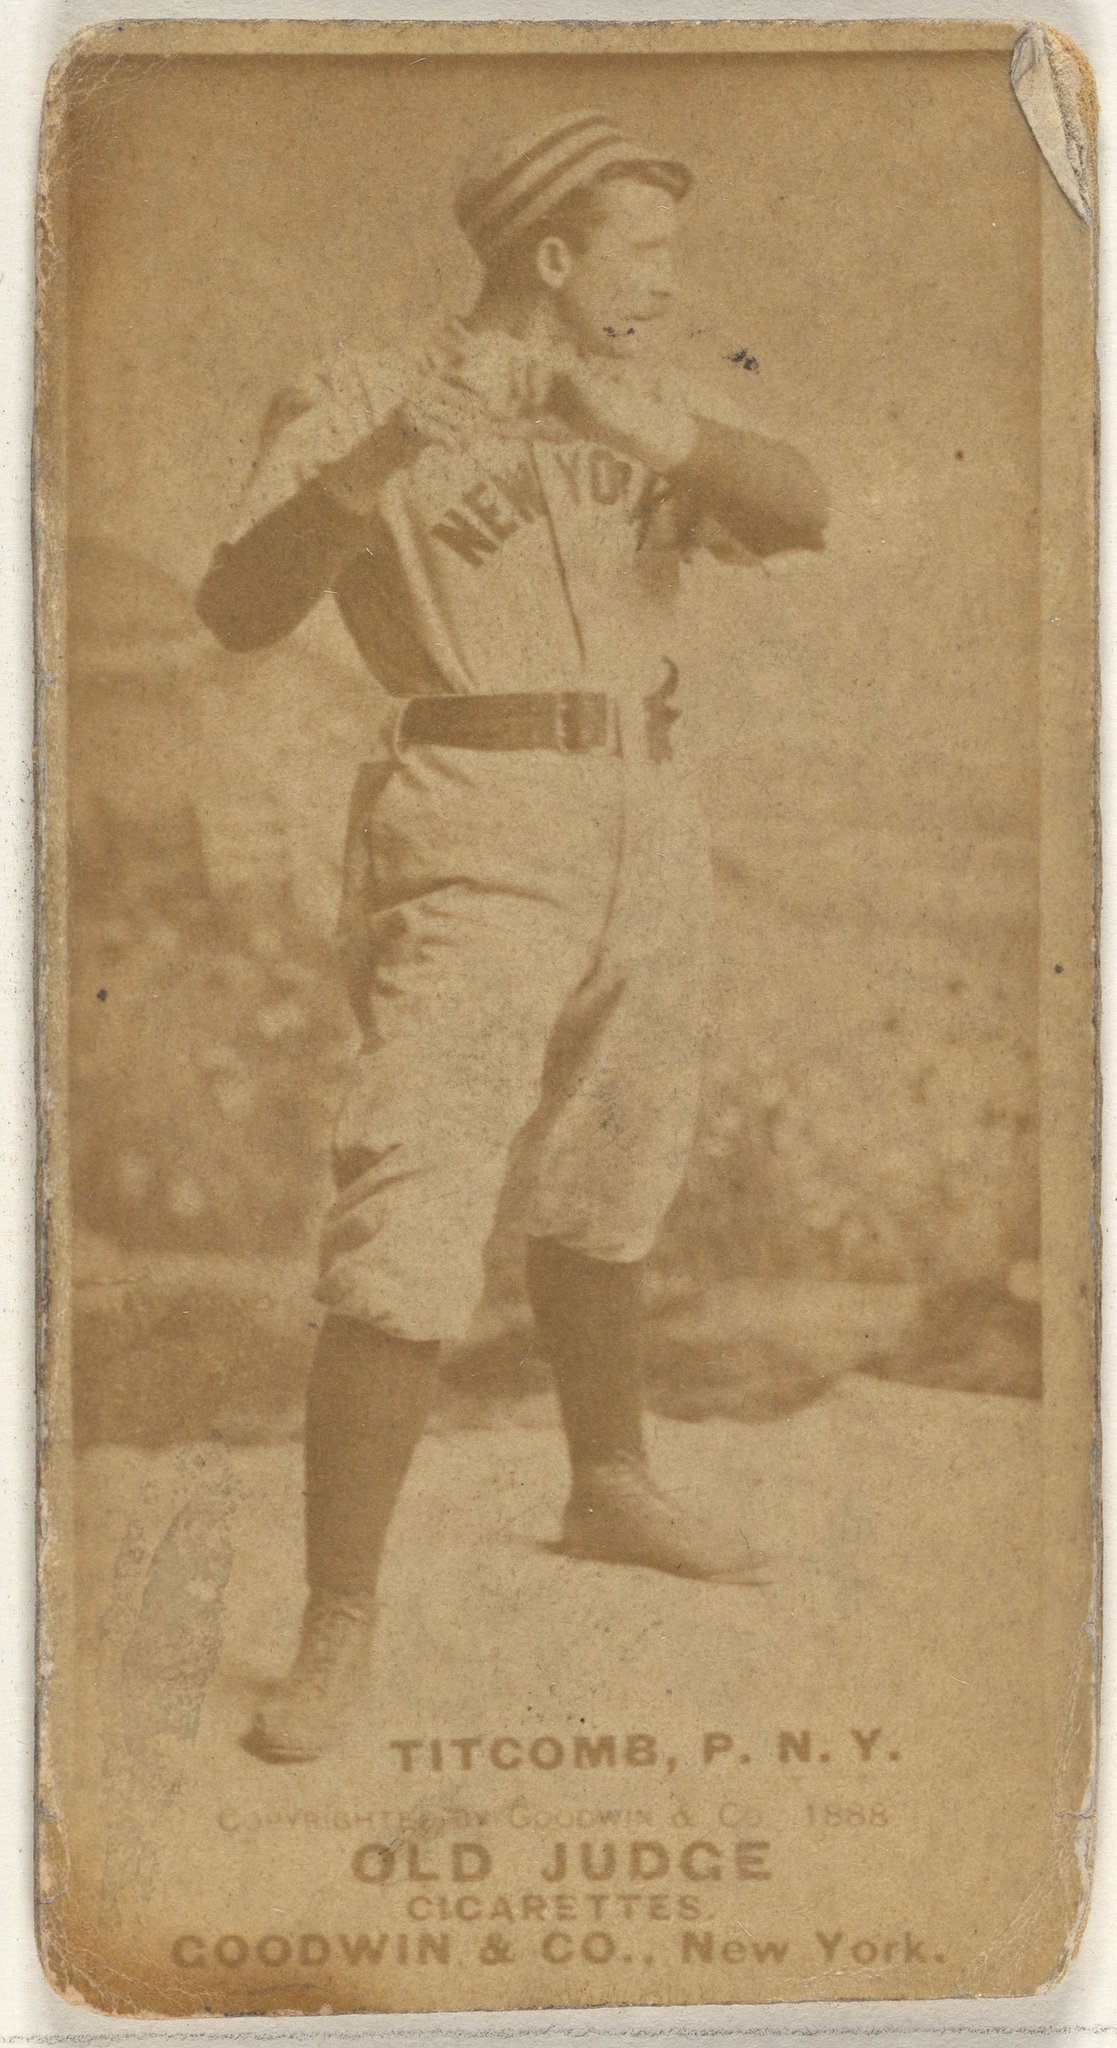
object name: baseball card, photograph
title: Ledell "Cannonball" Titcomb, Pitcher, New York, from the Old Judge series (N172) for Old Judge Cigarettes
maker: goodwin & company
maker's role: publisher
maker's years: 1850-1950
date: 1888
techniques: albumen silver print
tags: men,portraits,baseball,athletes